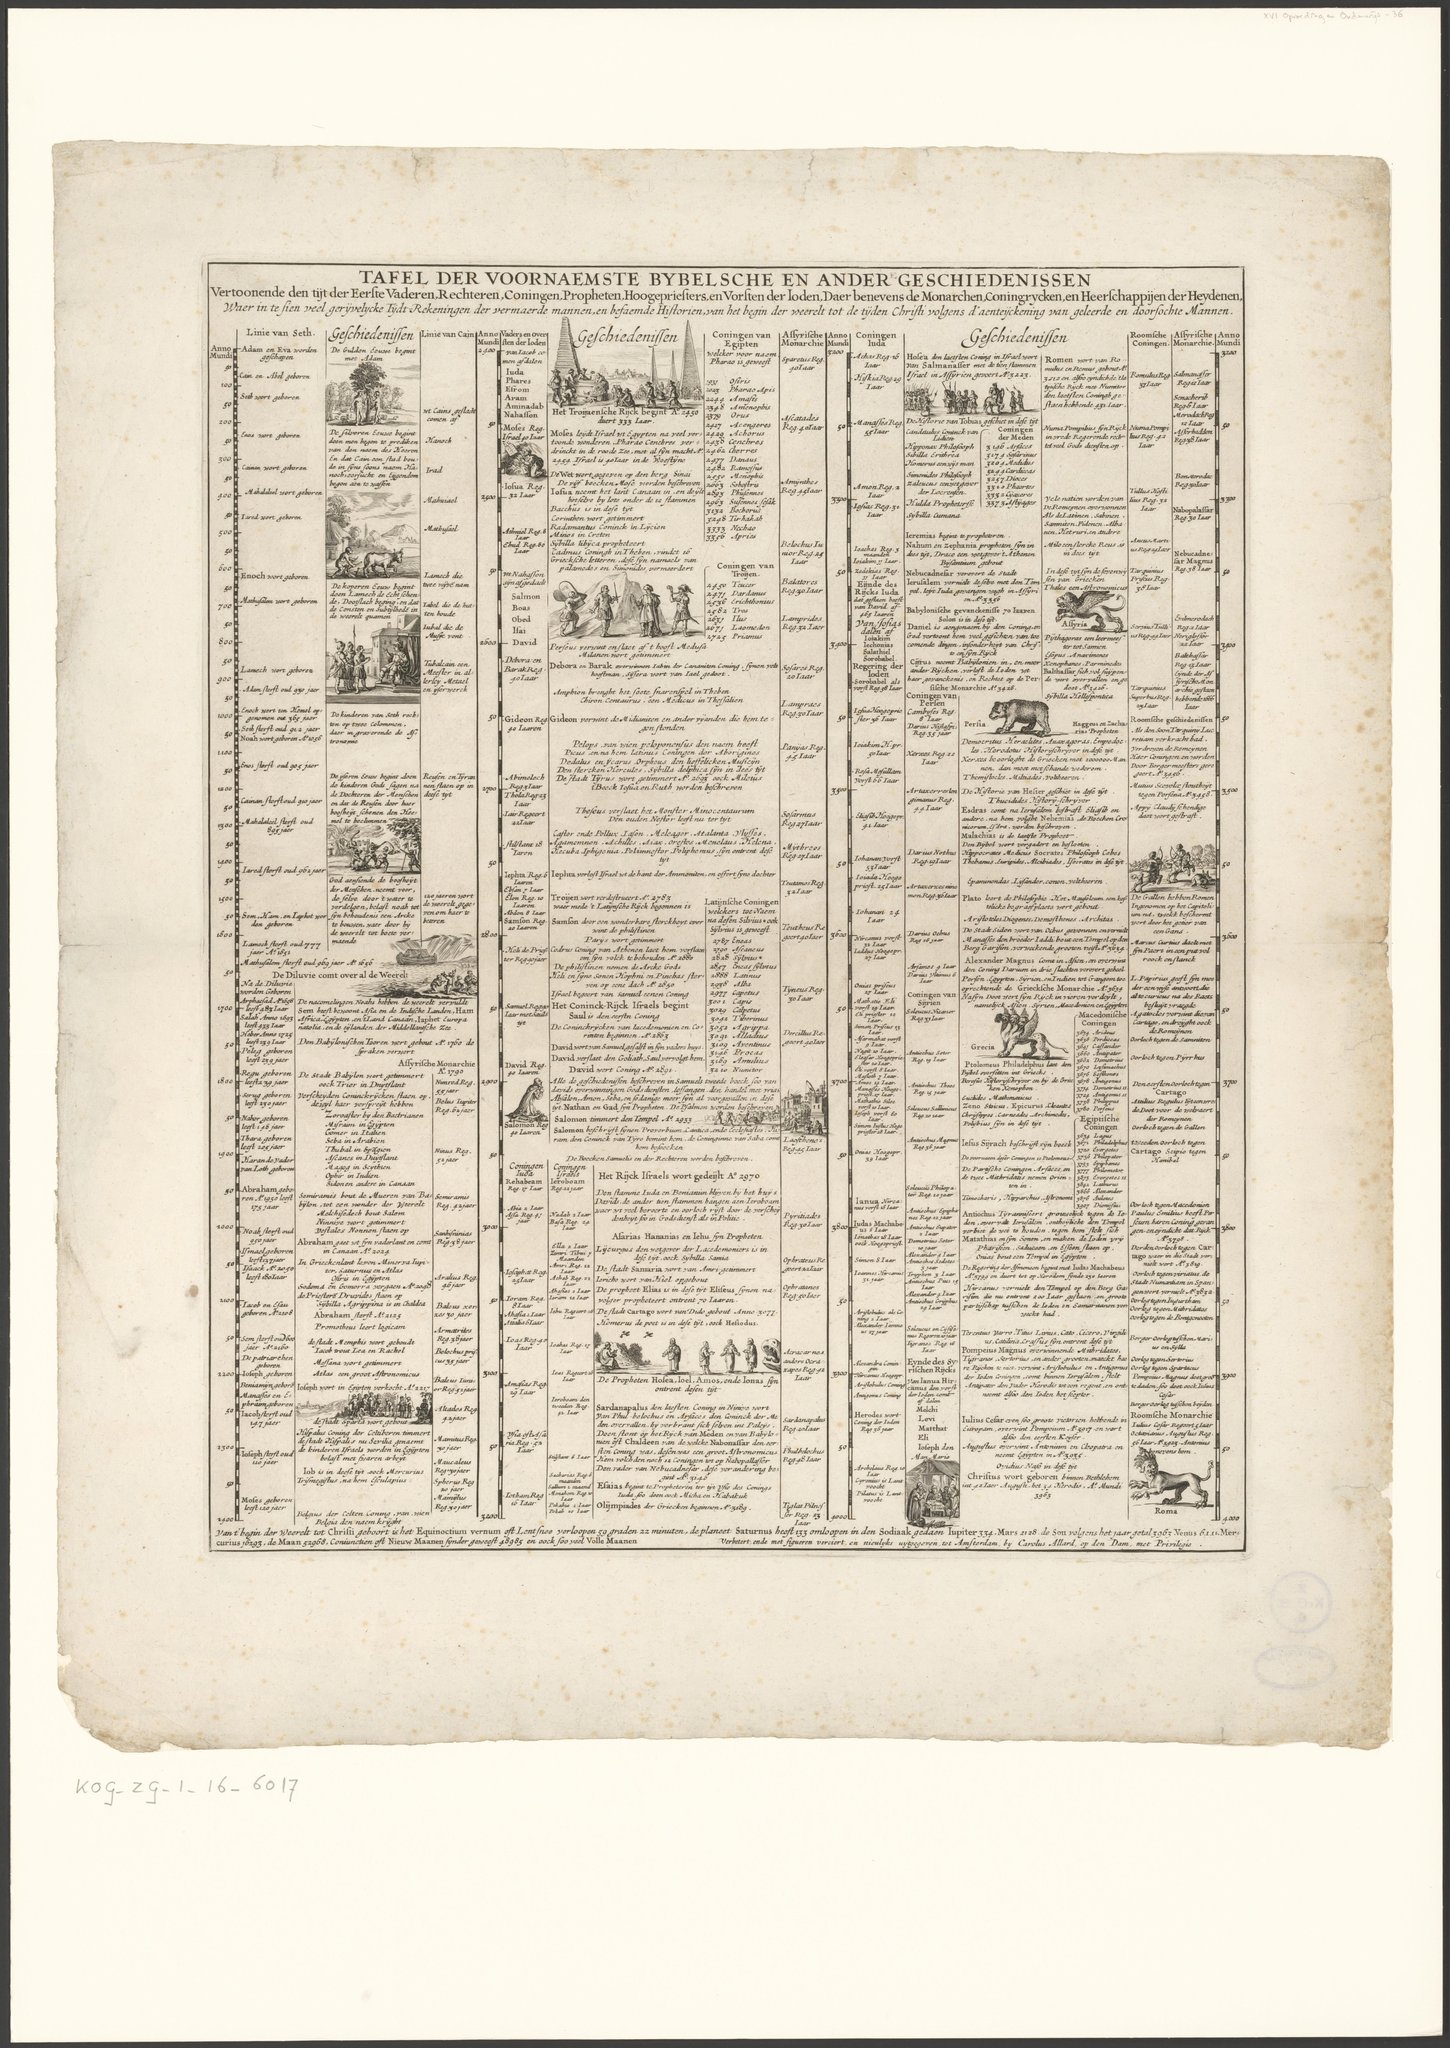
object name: print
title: Tafel der voornaemste Bybelsche en ander Geschiedenissen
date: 1683-1709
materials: paper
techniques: engraving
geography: amsterdam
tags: bible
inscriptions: collector's mark, collector's mark: Lugt 1641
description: Tabel met in een tijdlijn een overzicht van de belangrijkste historische gebeurtenissen beschreven in de Bijbel. Vanaf de schepping van Adam en Eva in het jaar 0 tot de geboorte van Christus in het jaar 3963. Onderwerpsrubrieken binnen de Atlas Zeden en Gewoonten: Onderwijs en Wetenschappen, Opvoeding en Onderwijs, Haneboeken en schoolprenten.